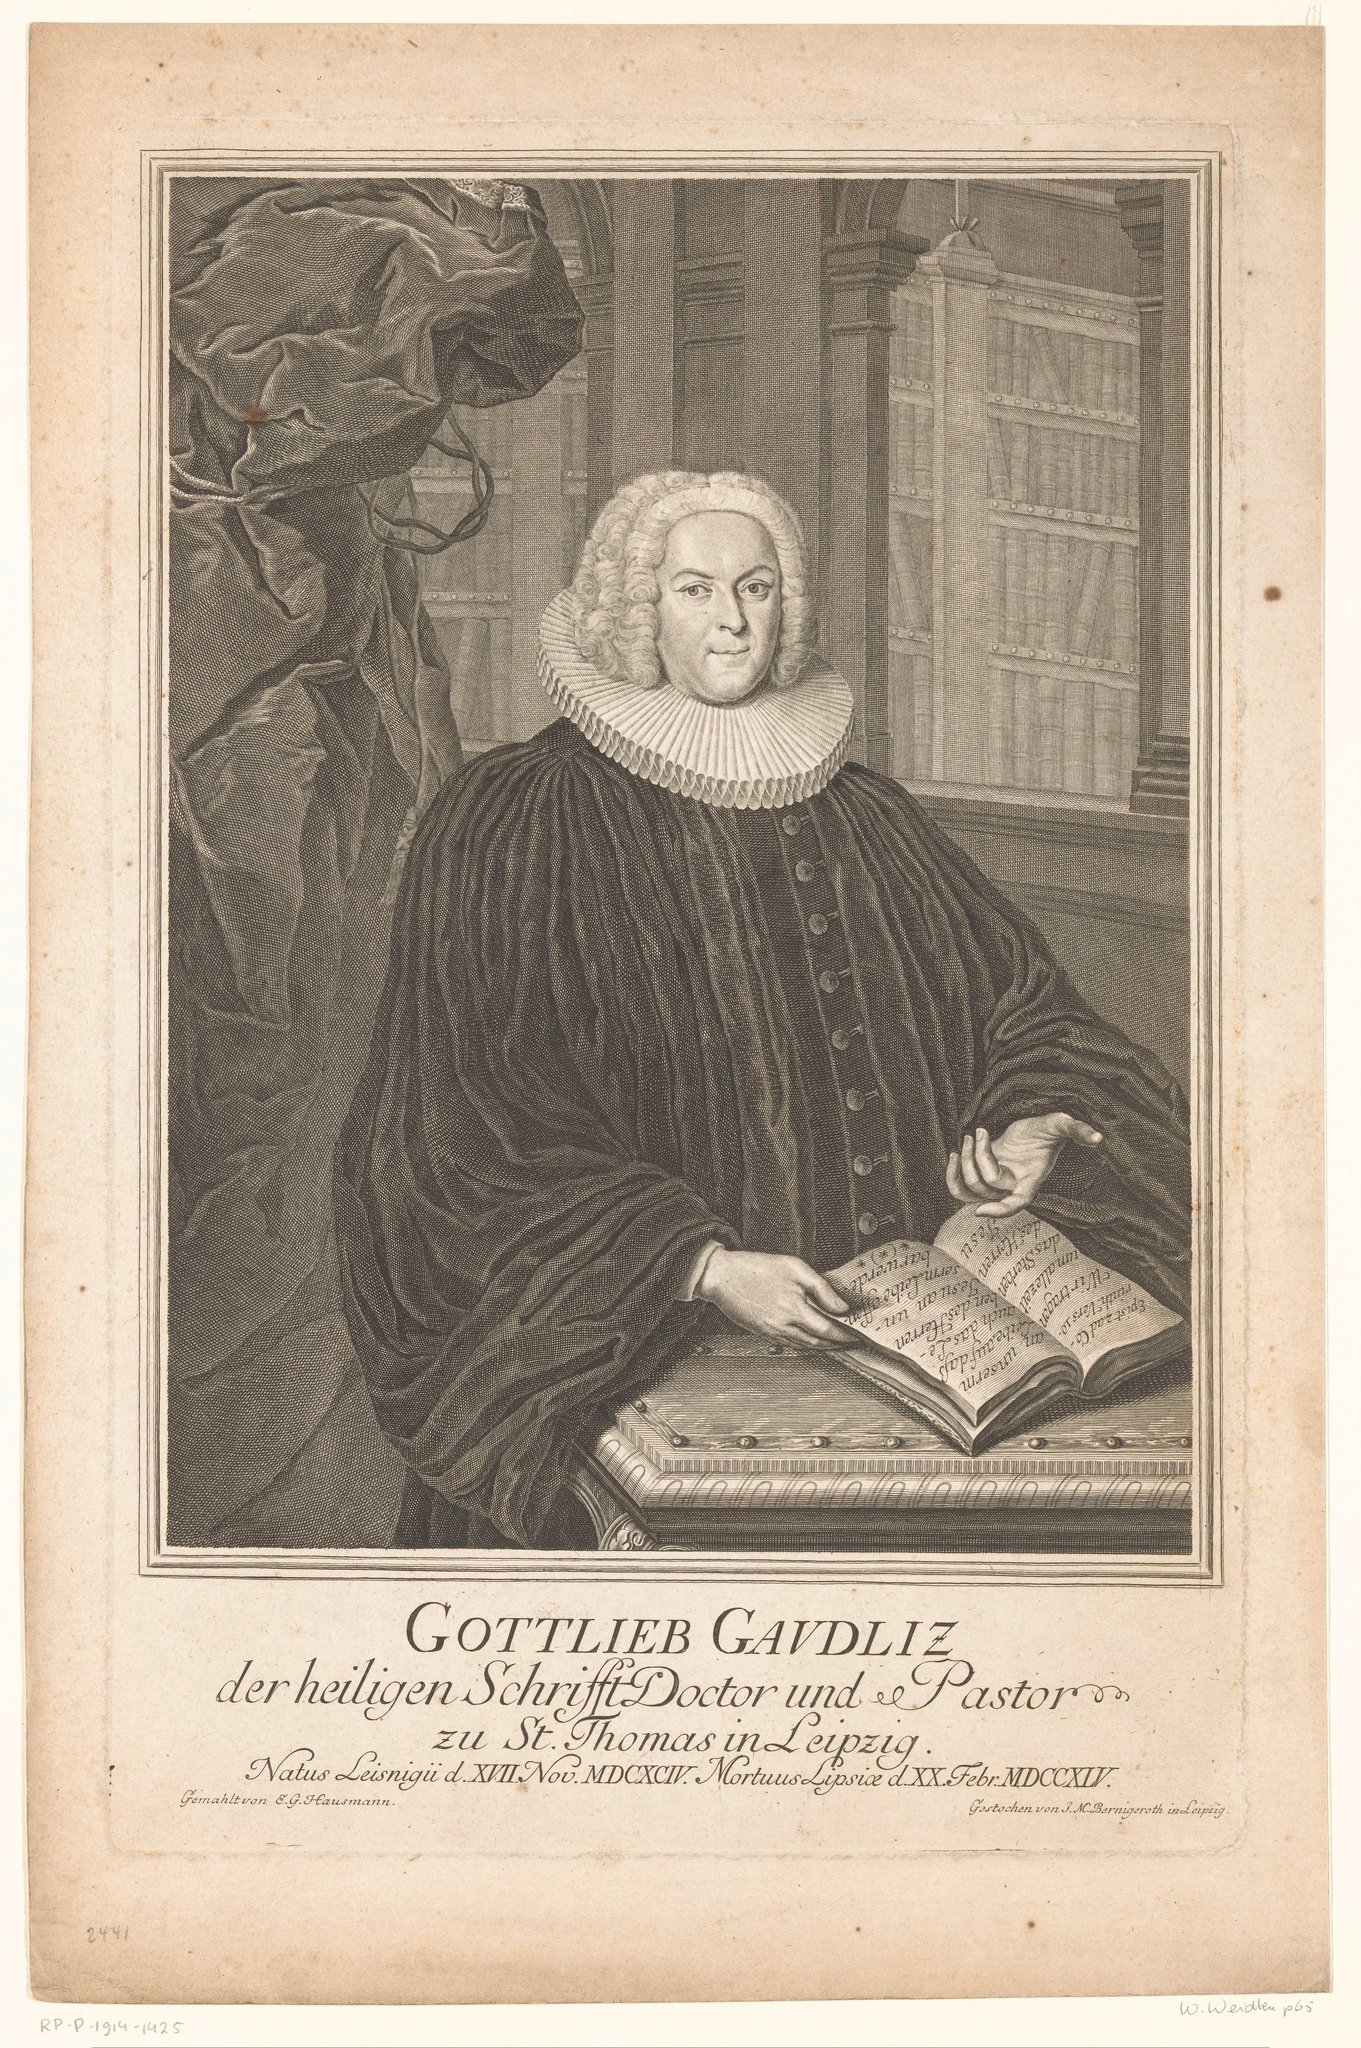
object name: print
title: Portret van Gottlieb Gaudlitz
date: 1745-1767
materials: paper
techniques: engraving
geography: leipzig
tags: bookshelves, historical persons, the bible as a book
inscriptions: collector's mark: Lugt 2228